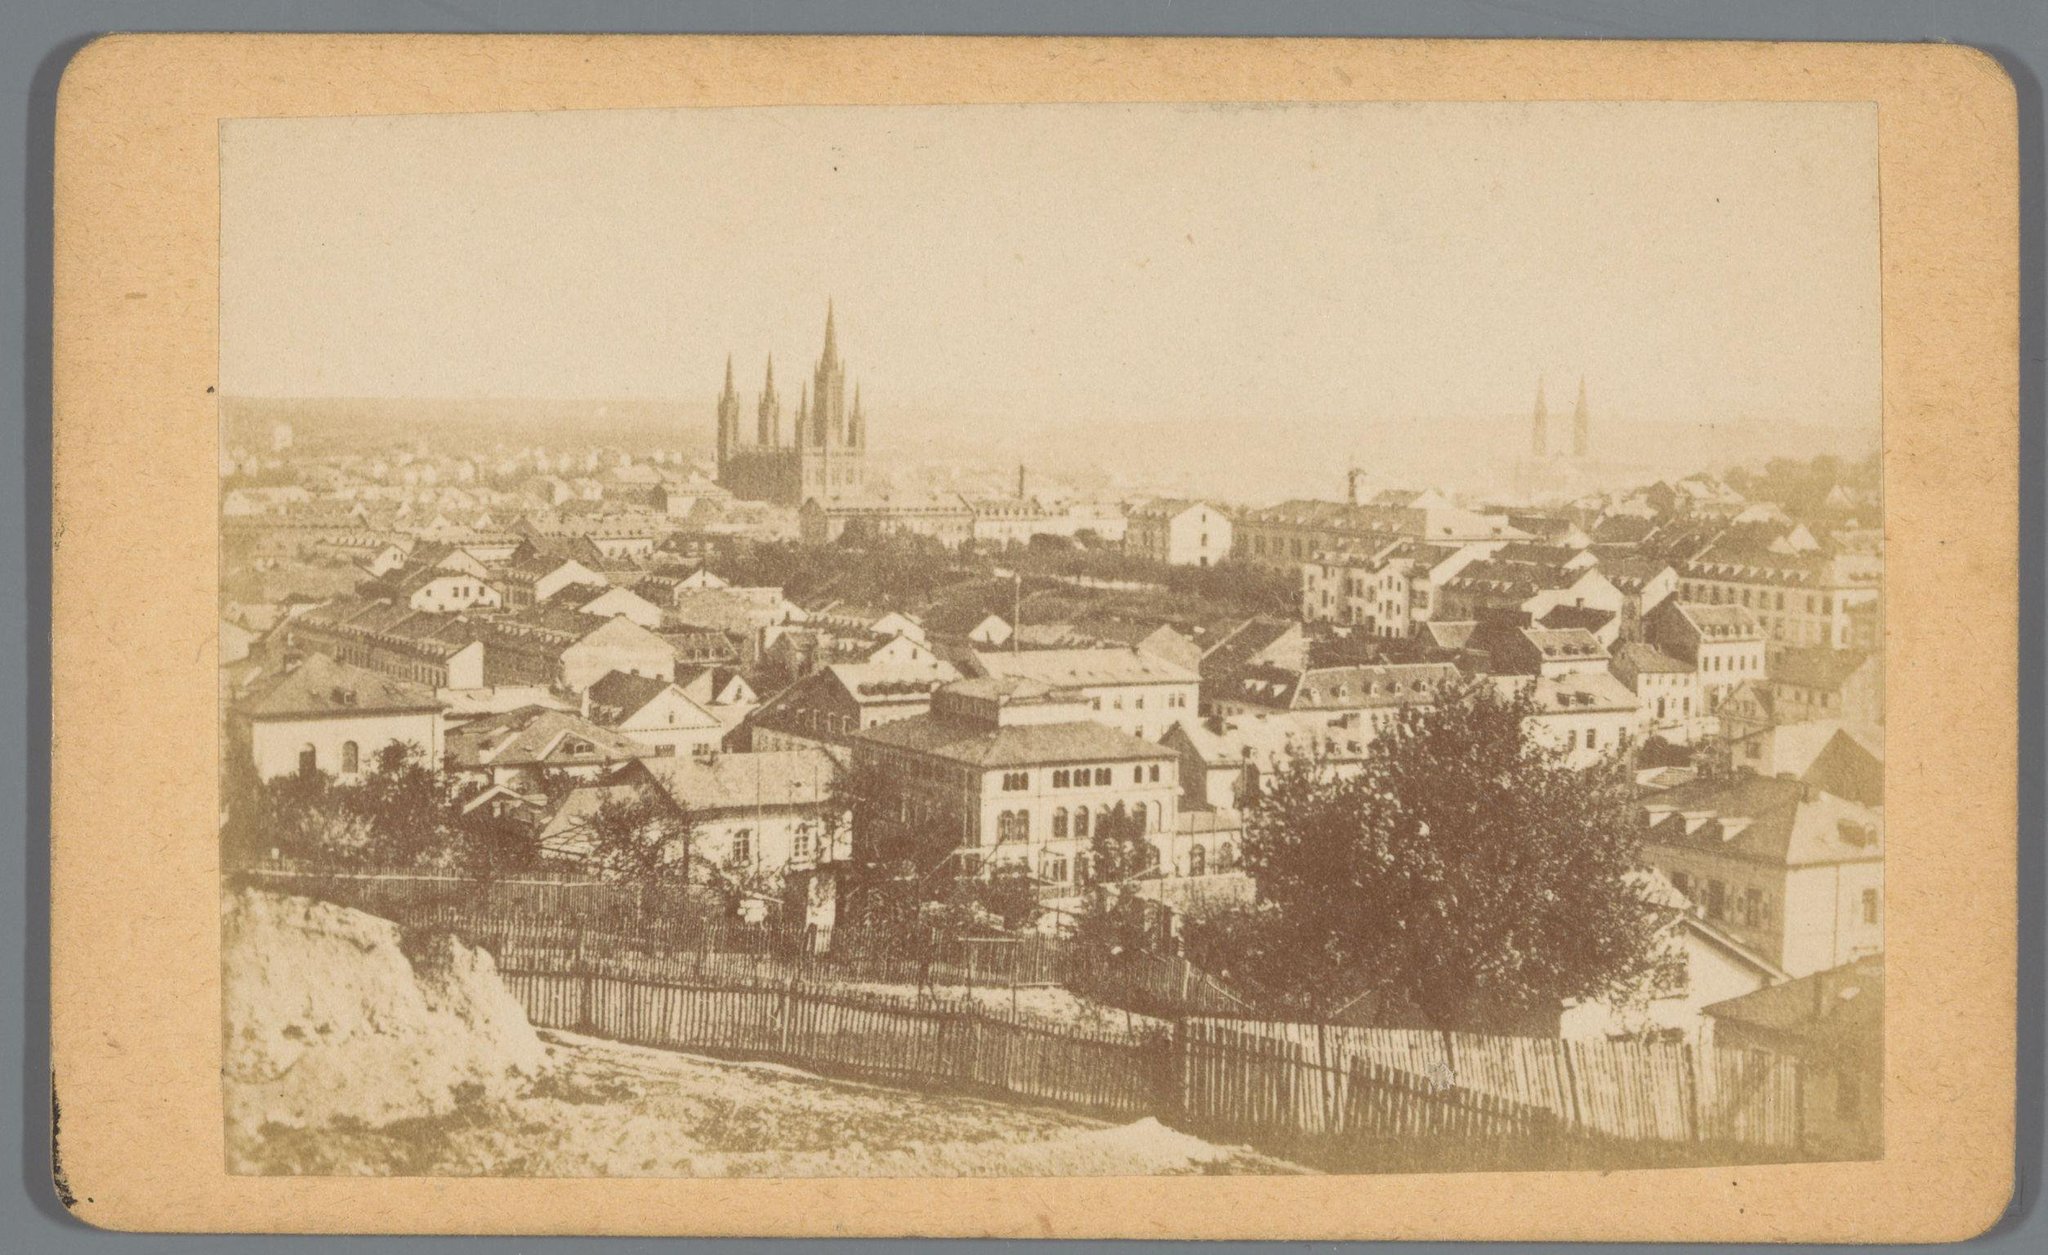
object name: carte de visite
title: Wiesbaden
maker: Anonymous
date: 1855-1885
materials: cardboard, paper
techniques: albumen print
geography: wiesbaden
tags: city-view in general; 'veduta'